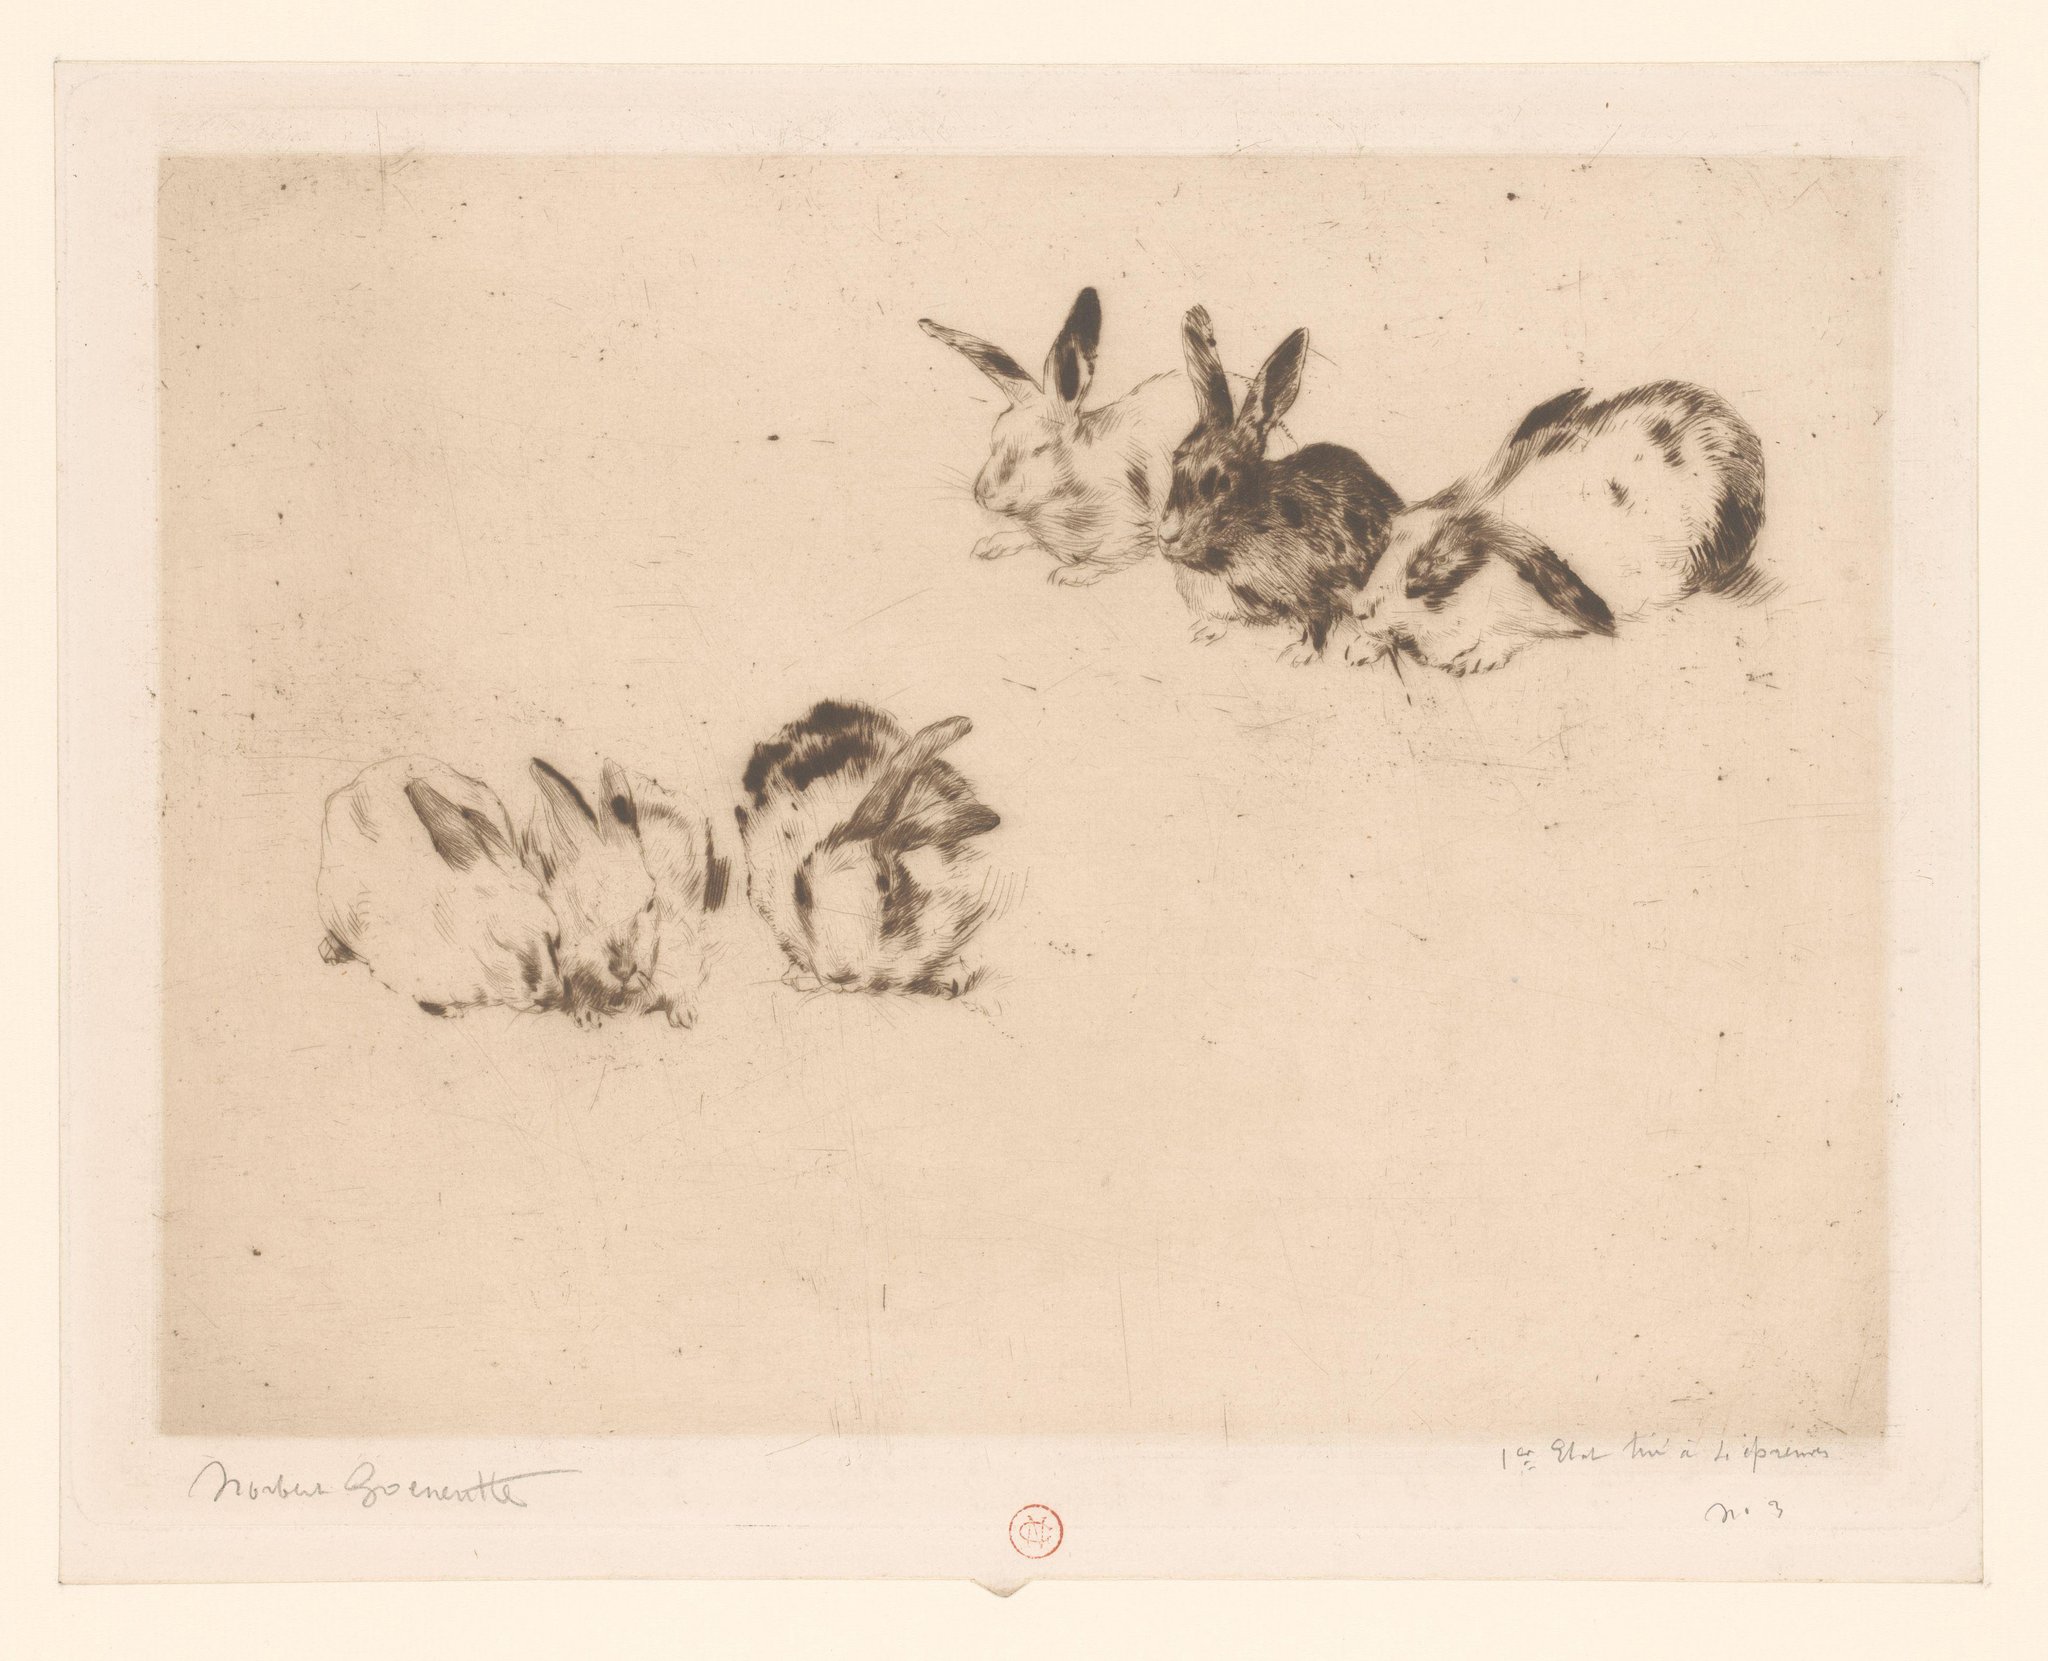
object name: print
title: Zes konijnen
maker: norbert goeneutte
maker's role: draughtsman, painter, print maker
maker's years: 1854-1894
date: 1889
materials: paper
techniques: drypoint, intaglio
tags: rodents: rabbit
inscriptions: collector's mark: Lugt 2228, stamp: Lugt 1182, collector's mark: Lugt 2760